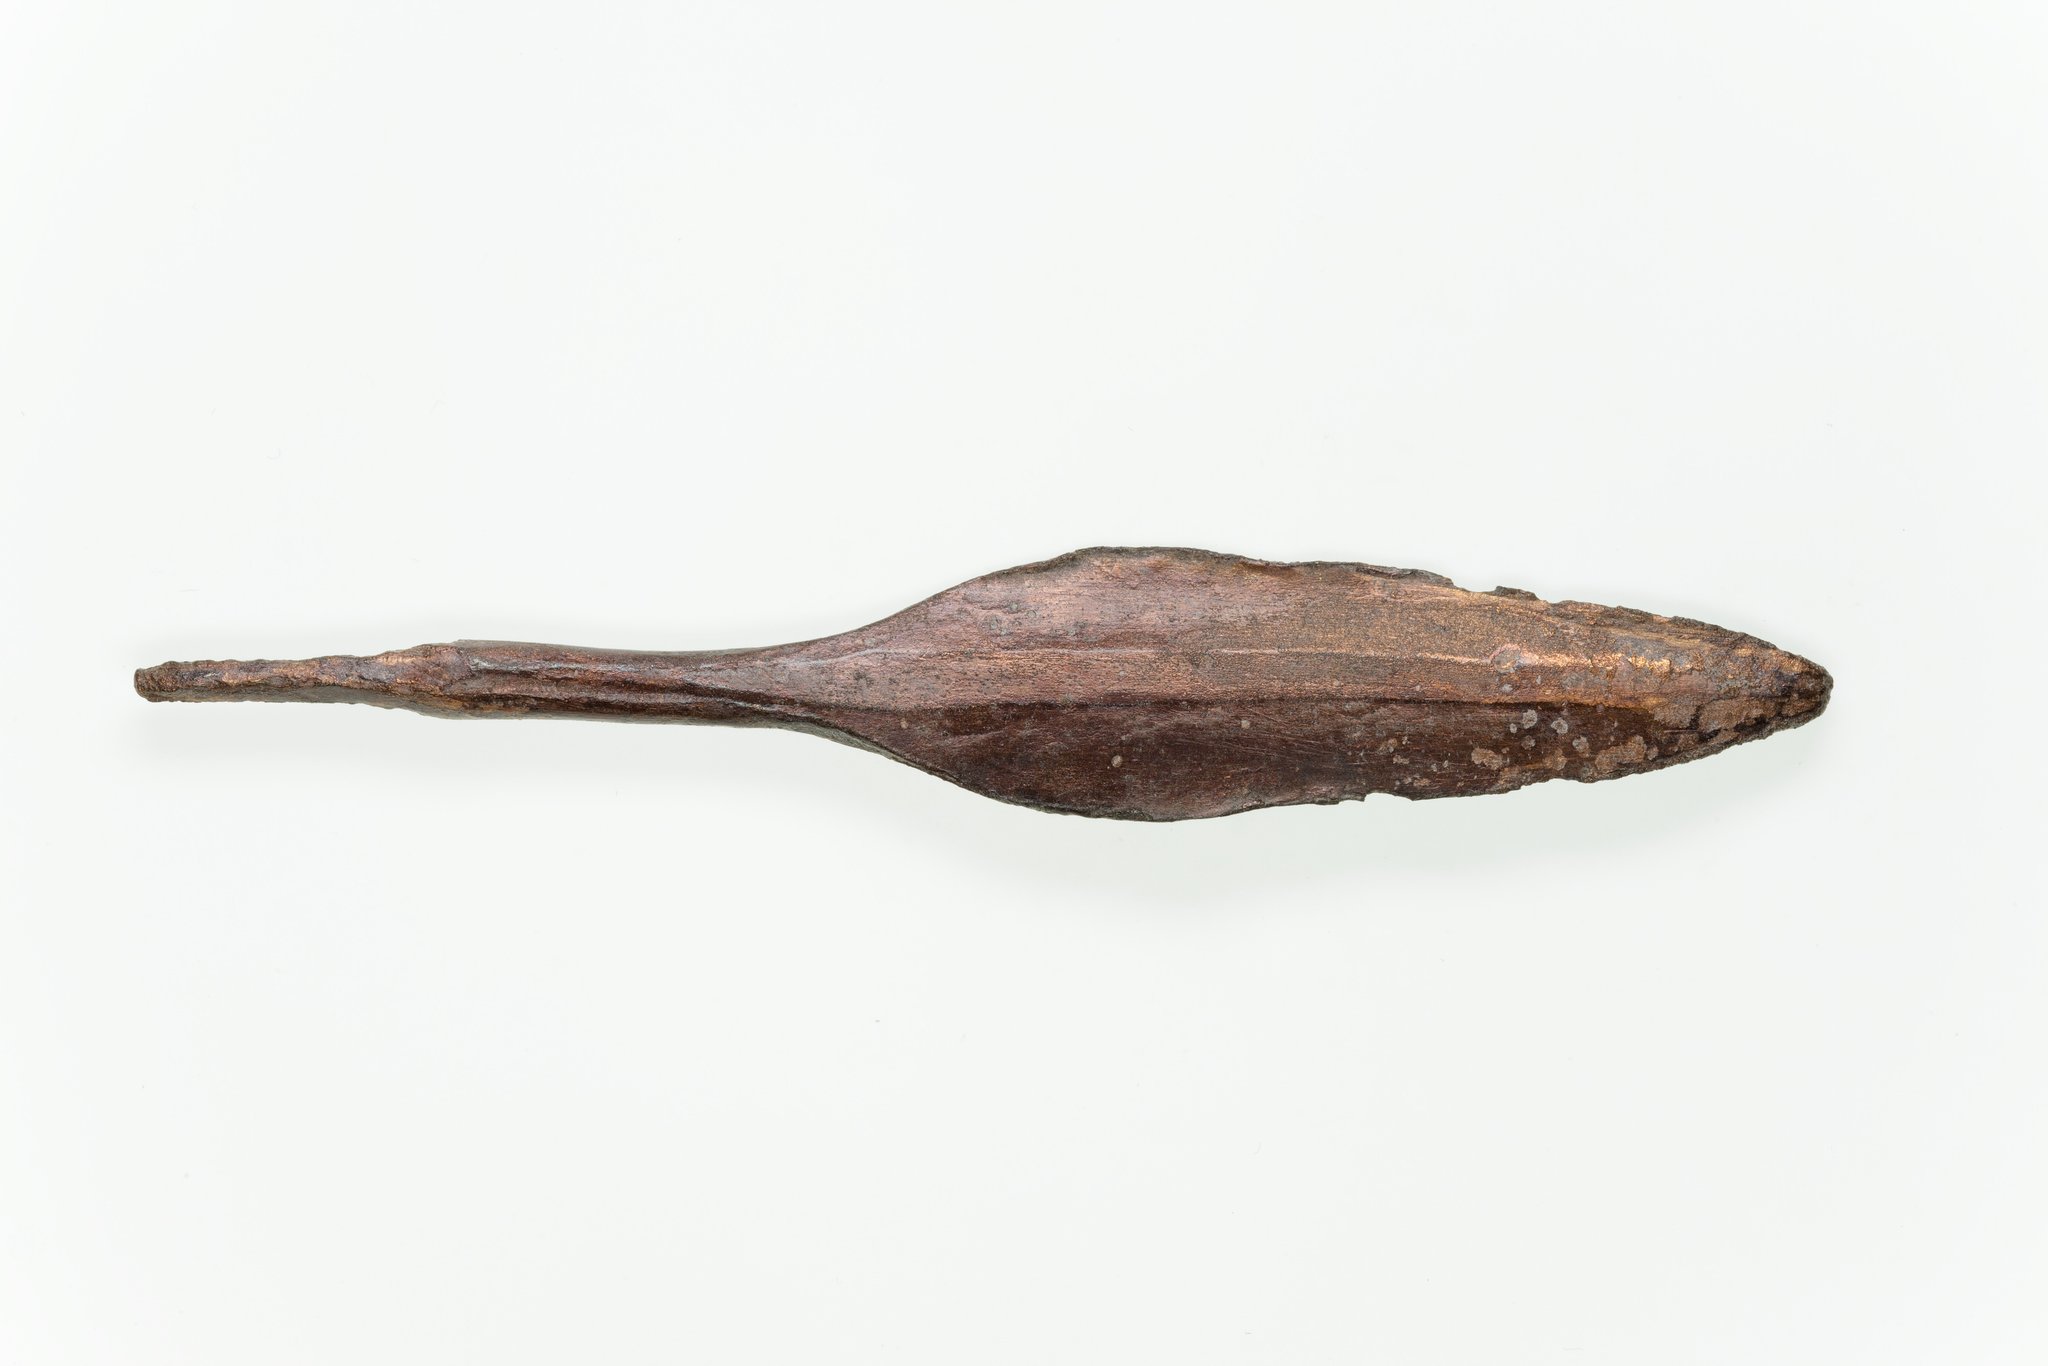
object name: arrow point, neferkhawet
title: Arrow or Javelin Point of Neferkhawet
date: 1504-1447 BCE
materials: bronze, copper alloy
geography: egypt